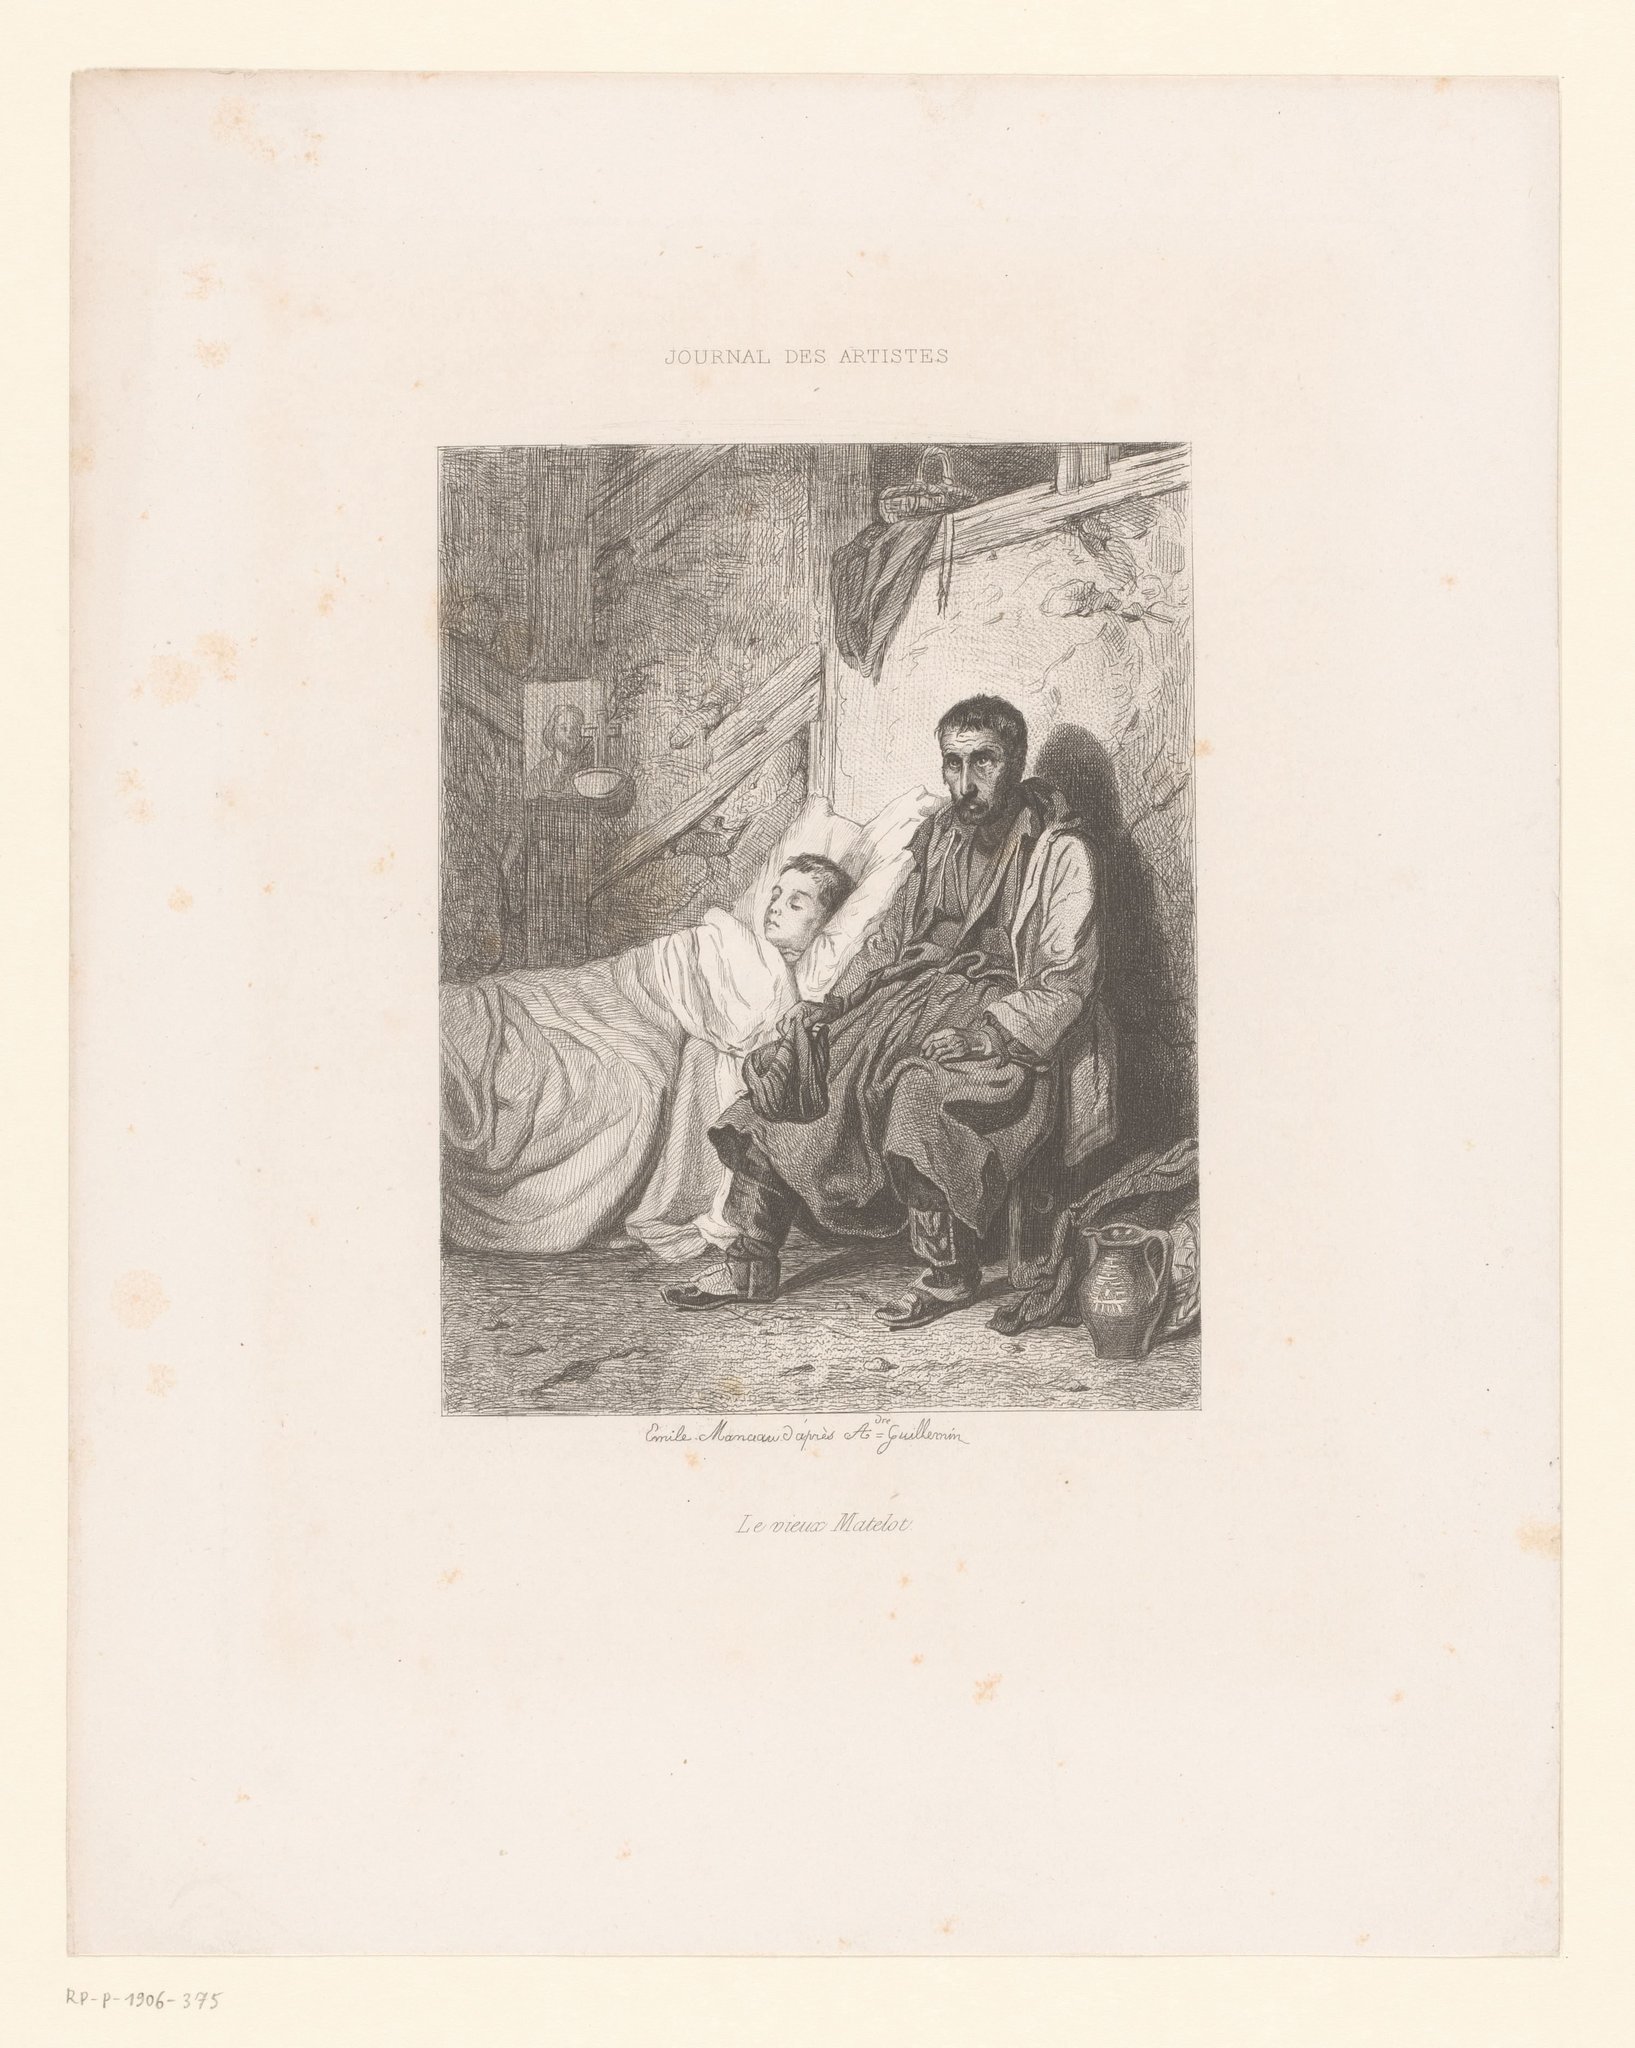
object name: print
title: Man op stoel naast een slapend kind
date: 1849-1867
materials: paper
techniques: etching, roulette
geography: france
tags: sitting figure, watching a sleeping child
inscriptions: collector's mark: Lugt 2228